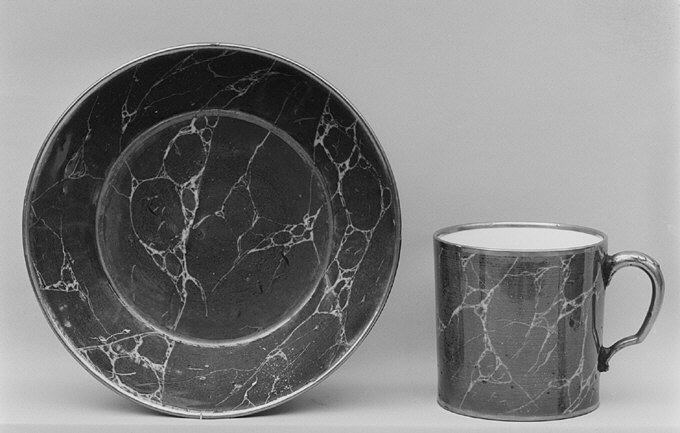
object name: saucer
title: Saucer (soucoupe)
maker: sèvres manufactory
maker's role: manufactory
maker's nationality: french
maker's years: 1740-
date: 1781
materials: soft paste porcelain